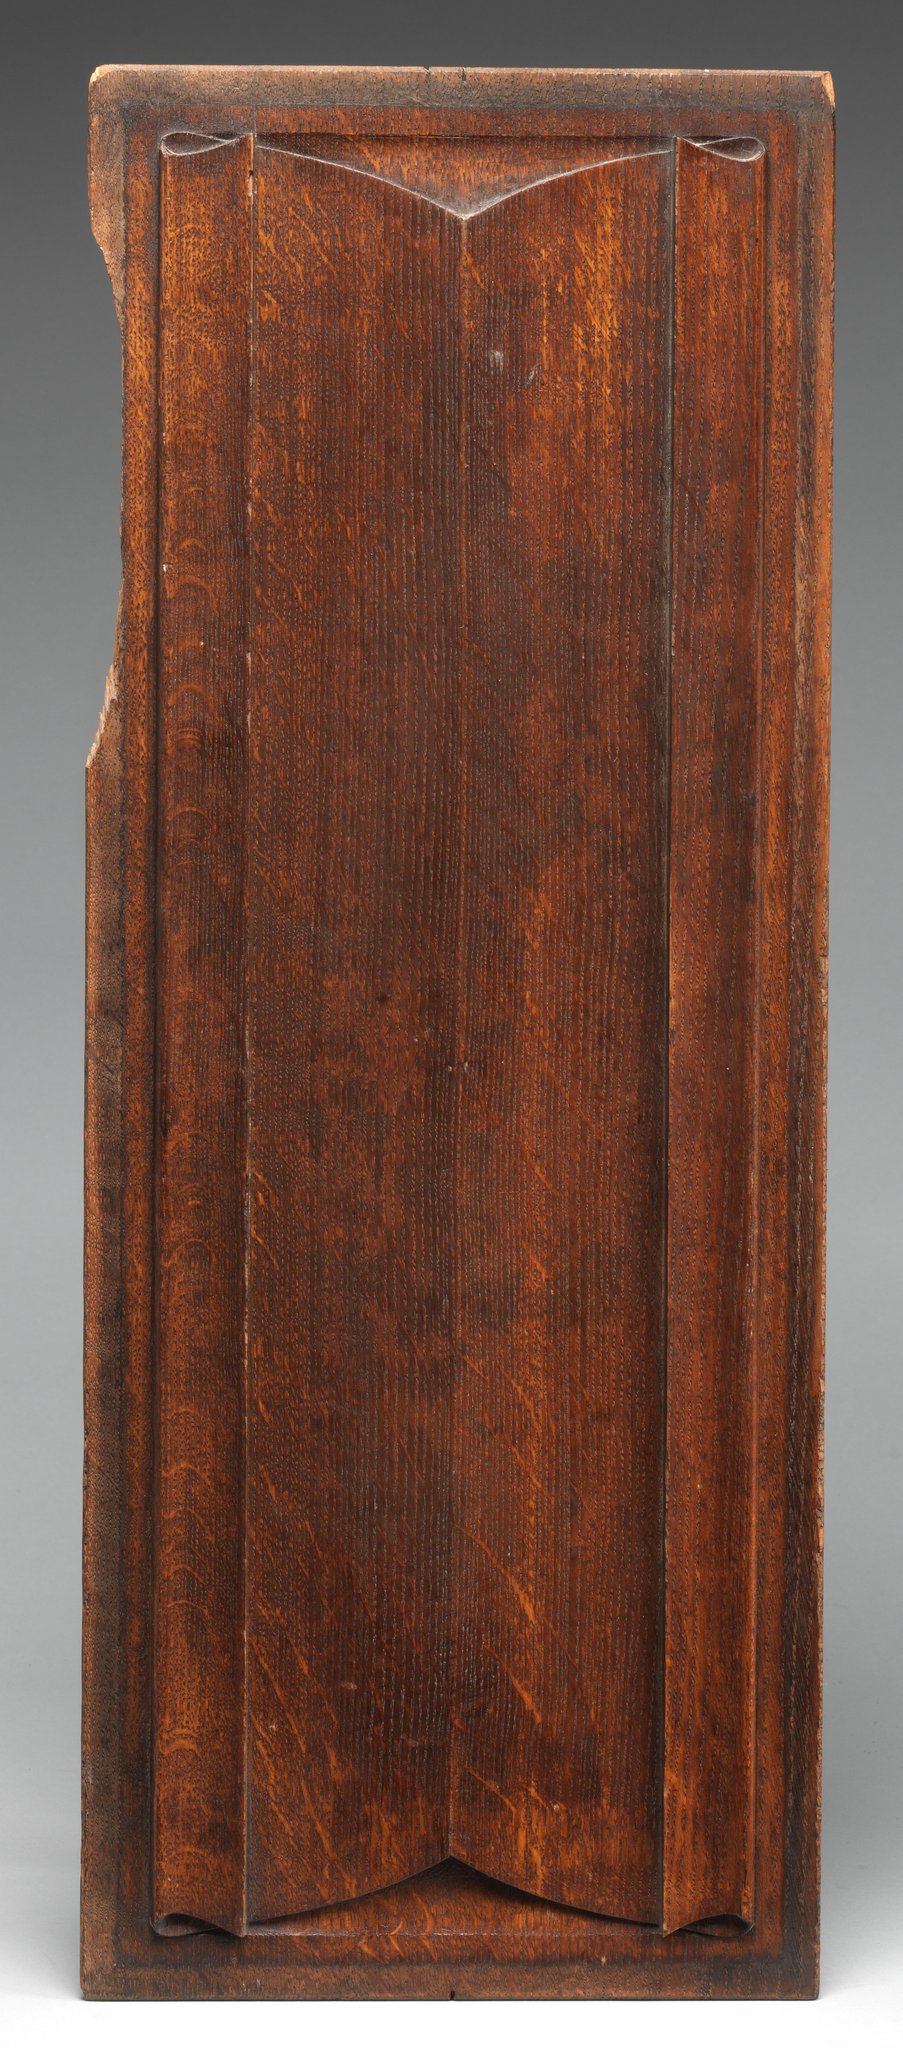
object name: panel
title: Panel from the Palace of Westminster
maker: augustus welby northmore pugin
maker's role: designer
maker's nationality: british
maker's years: 1812-1852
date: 1847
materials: wood